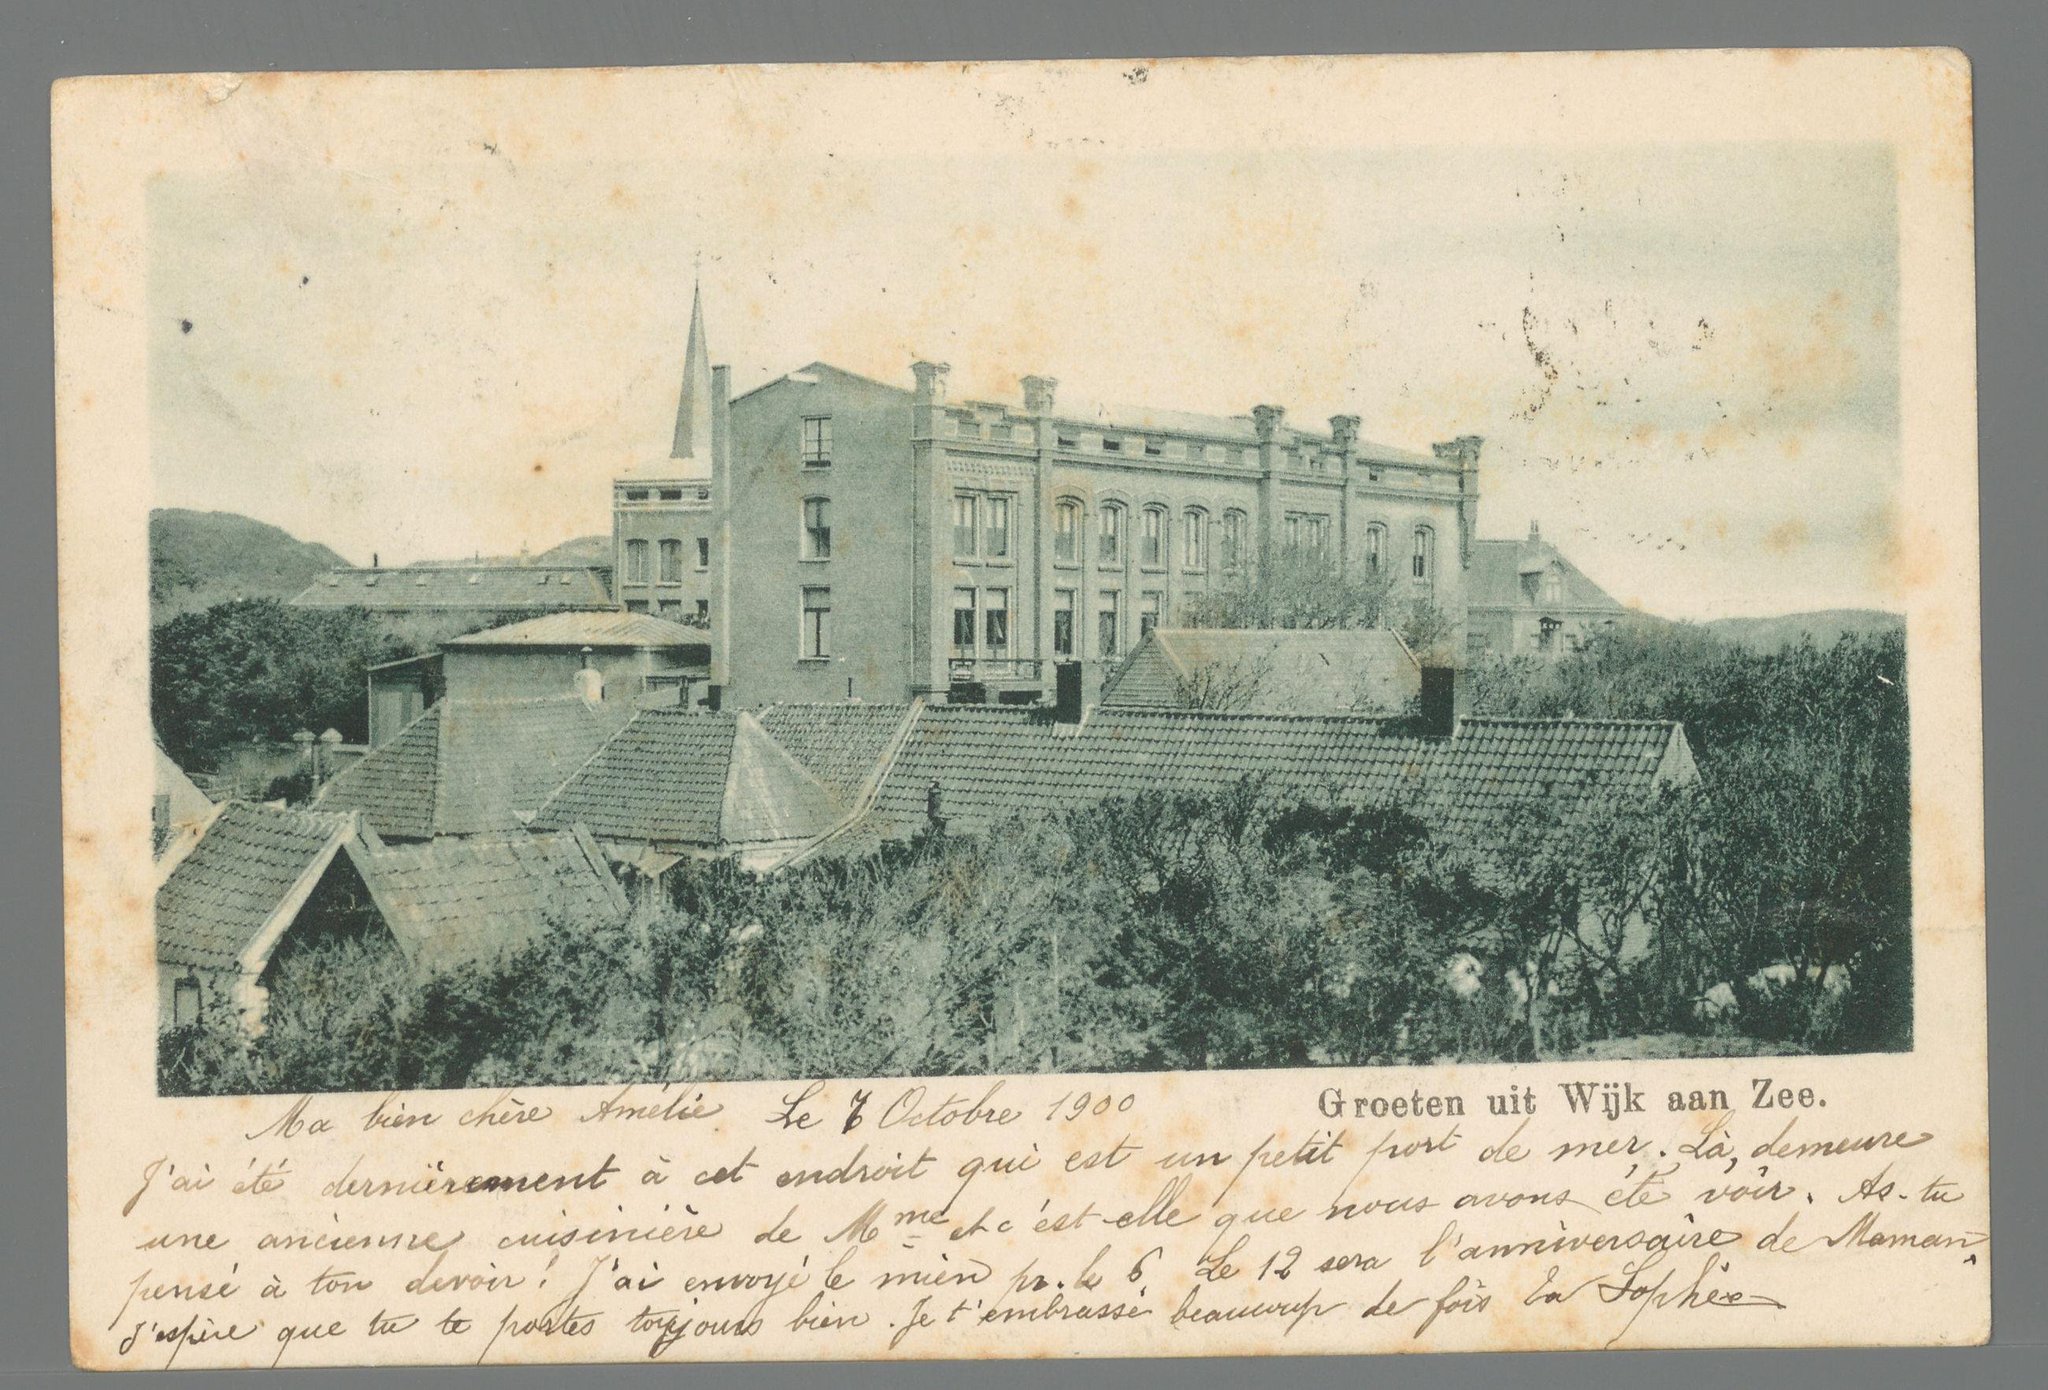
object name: photomechanical print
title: Groeten uit Wijk aan Zee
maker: Anonymous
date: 1895-1900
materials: cardboard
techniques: photograph, writing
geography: wijk aan zee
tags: city-view, and landscape with man-made constructions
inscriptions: postage stamp